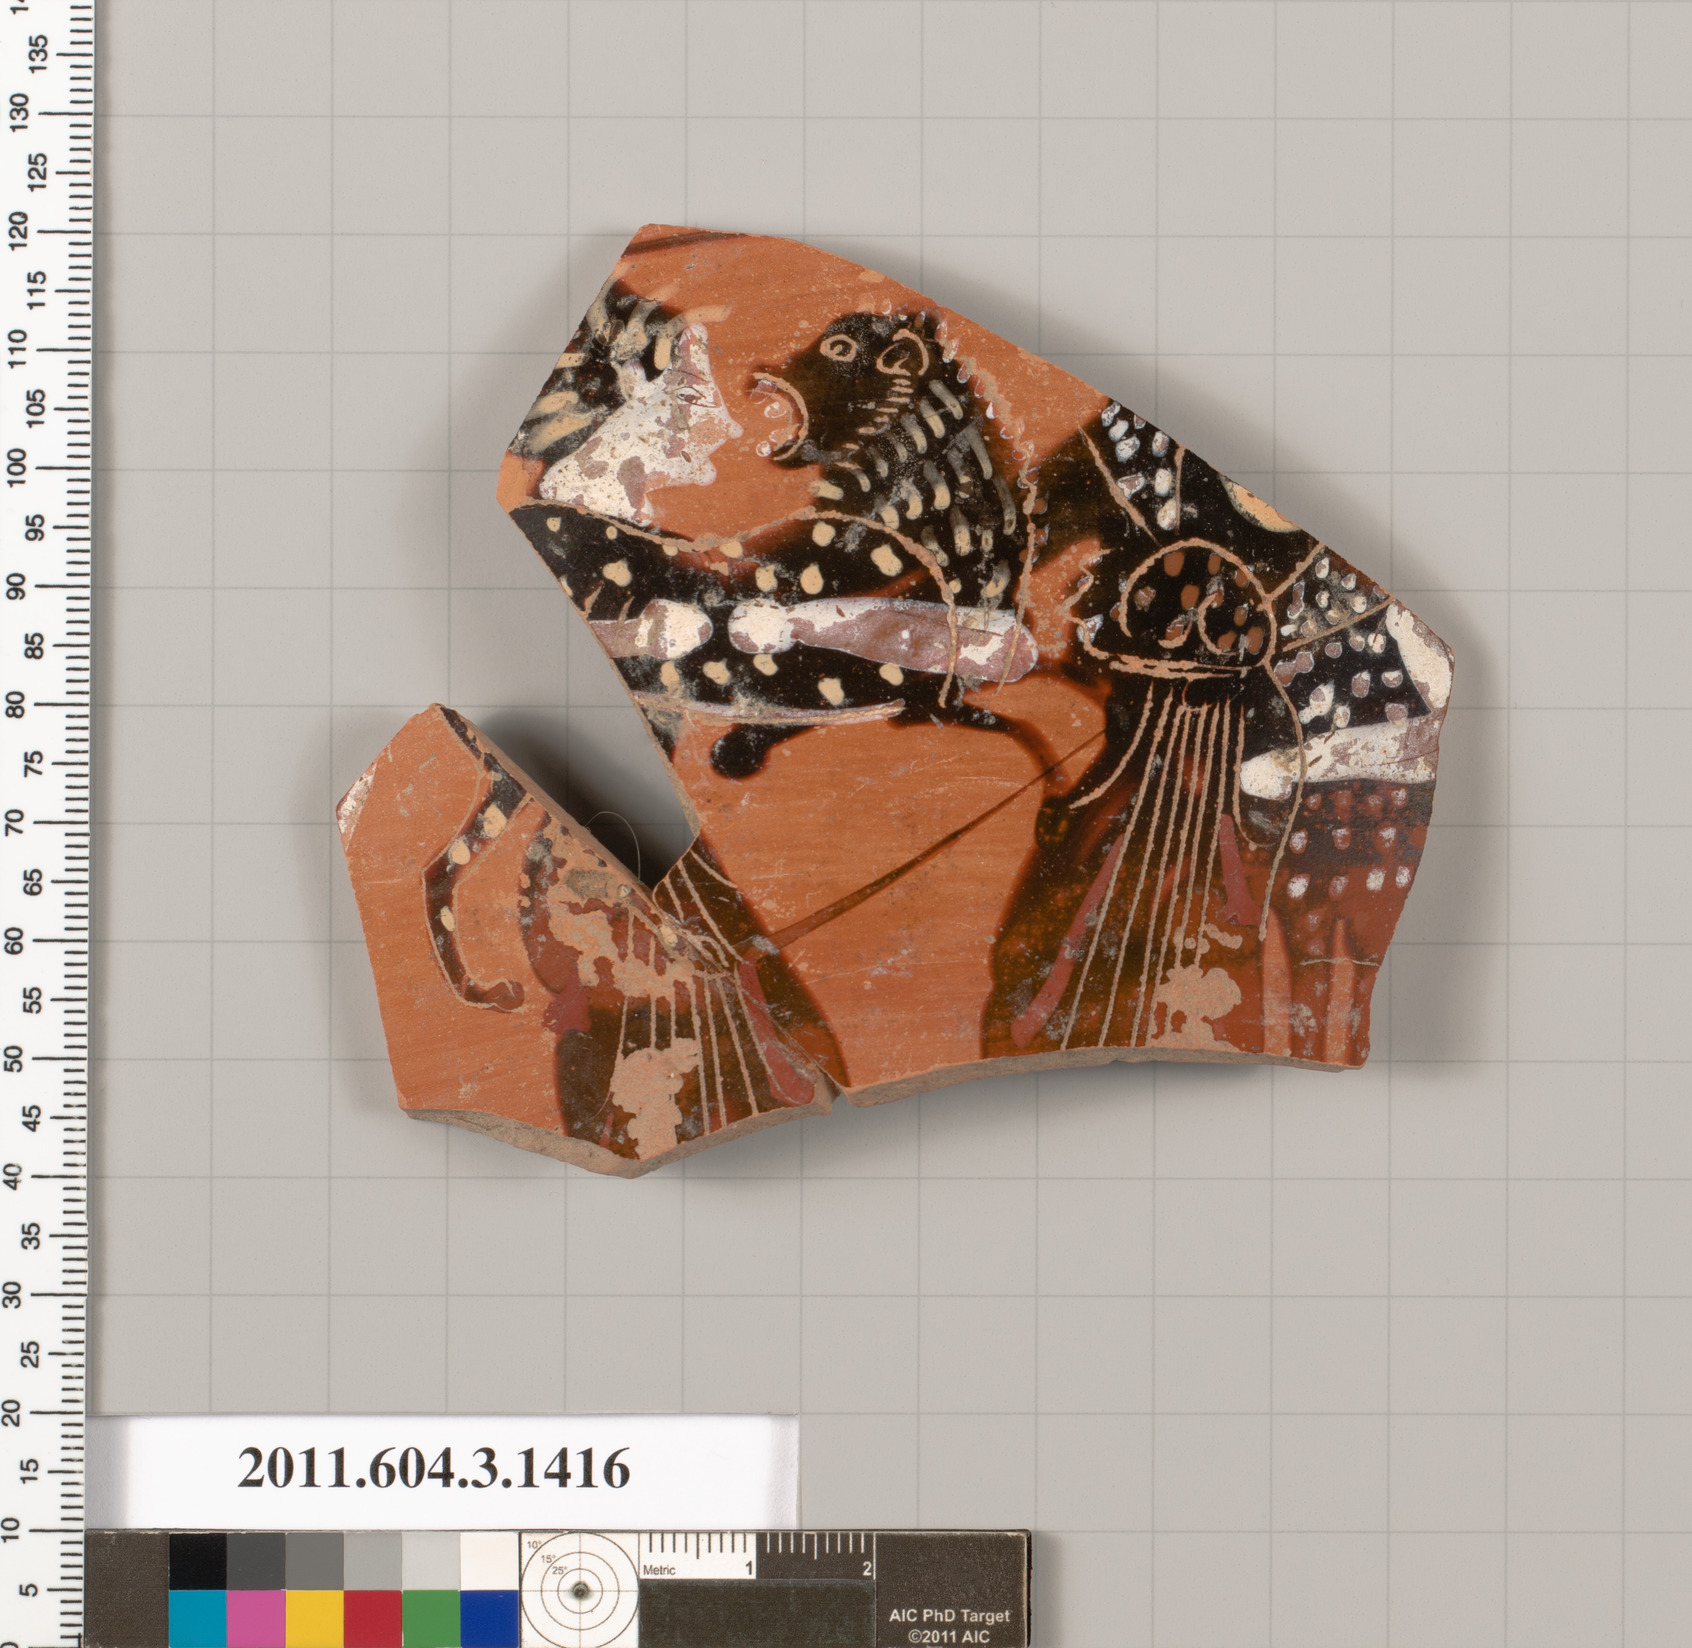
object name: skyphos fragment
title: Terracotta fragment of a skyphos (deep drinking cup)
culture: greek, attic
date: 534-501 BCE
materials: terracotta